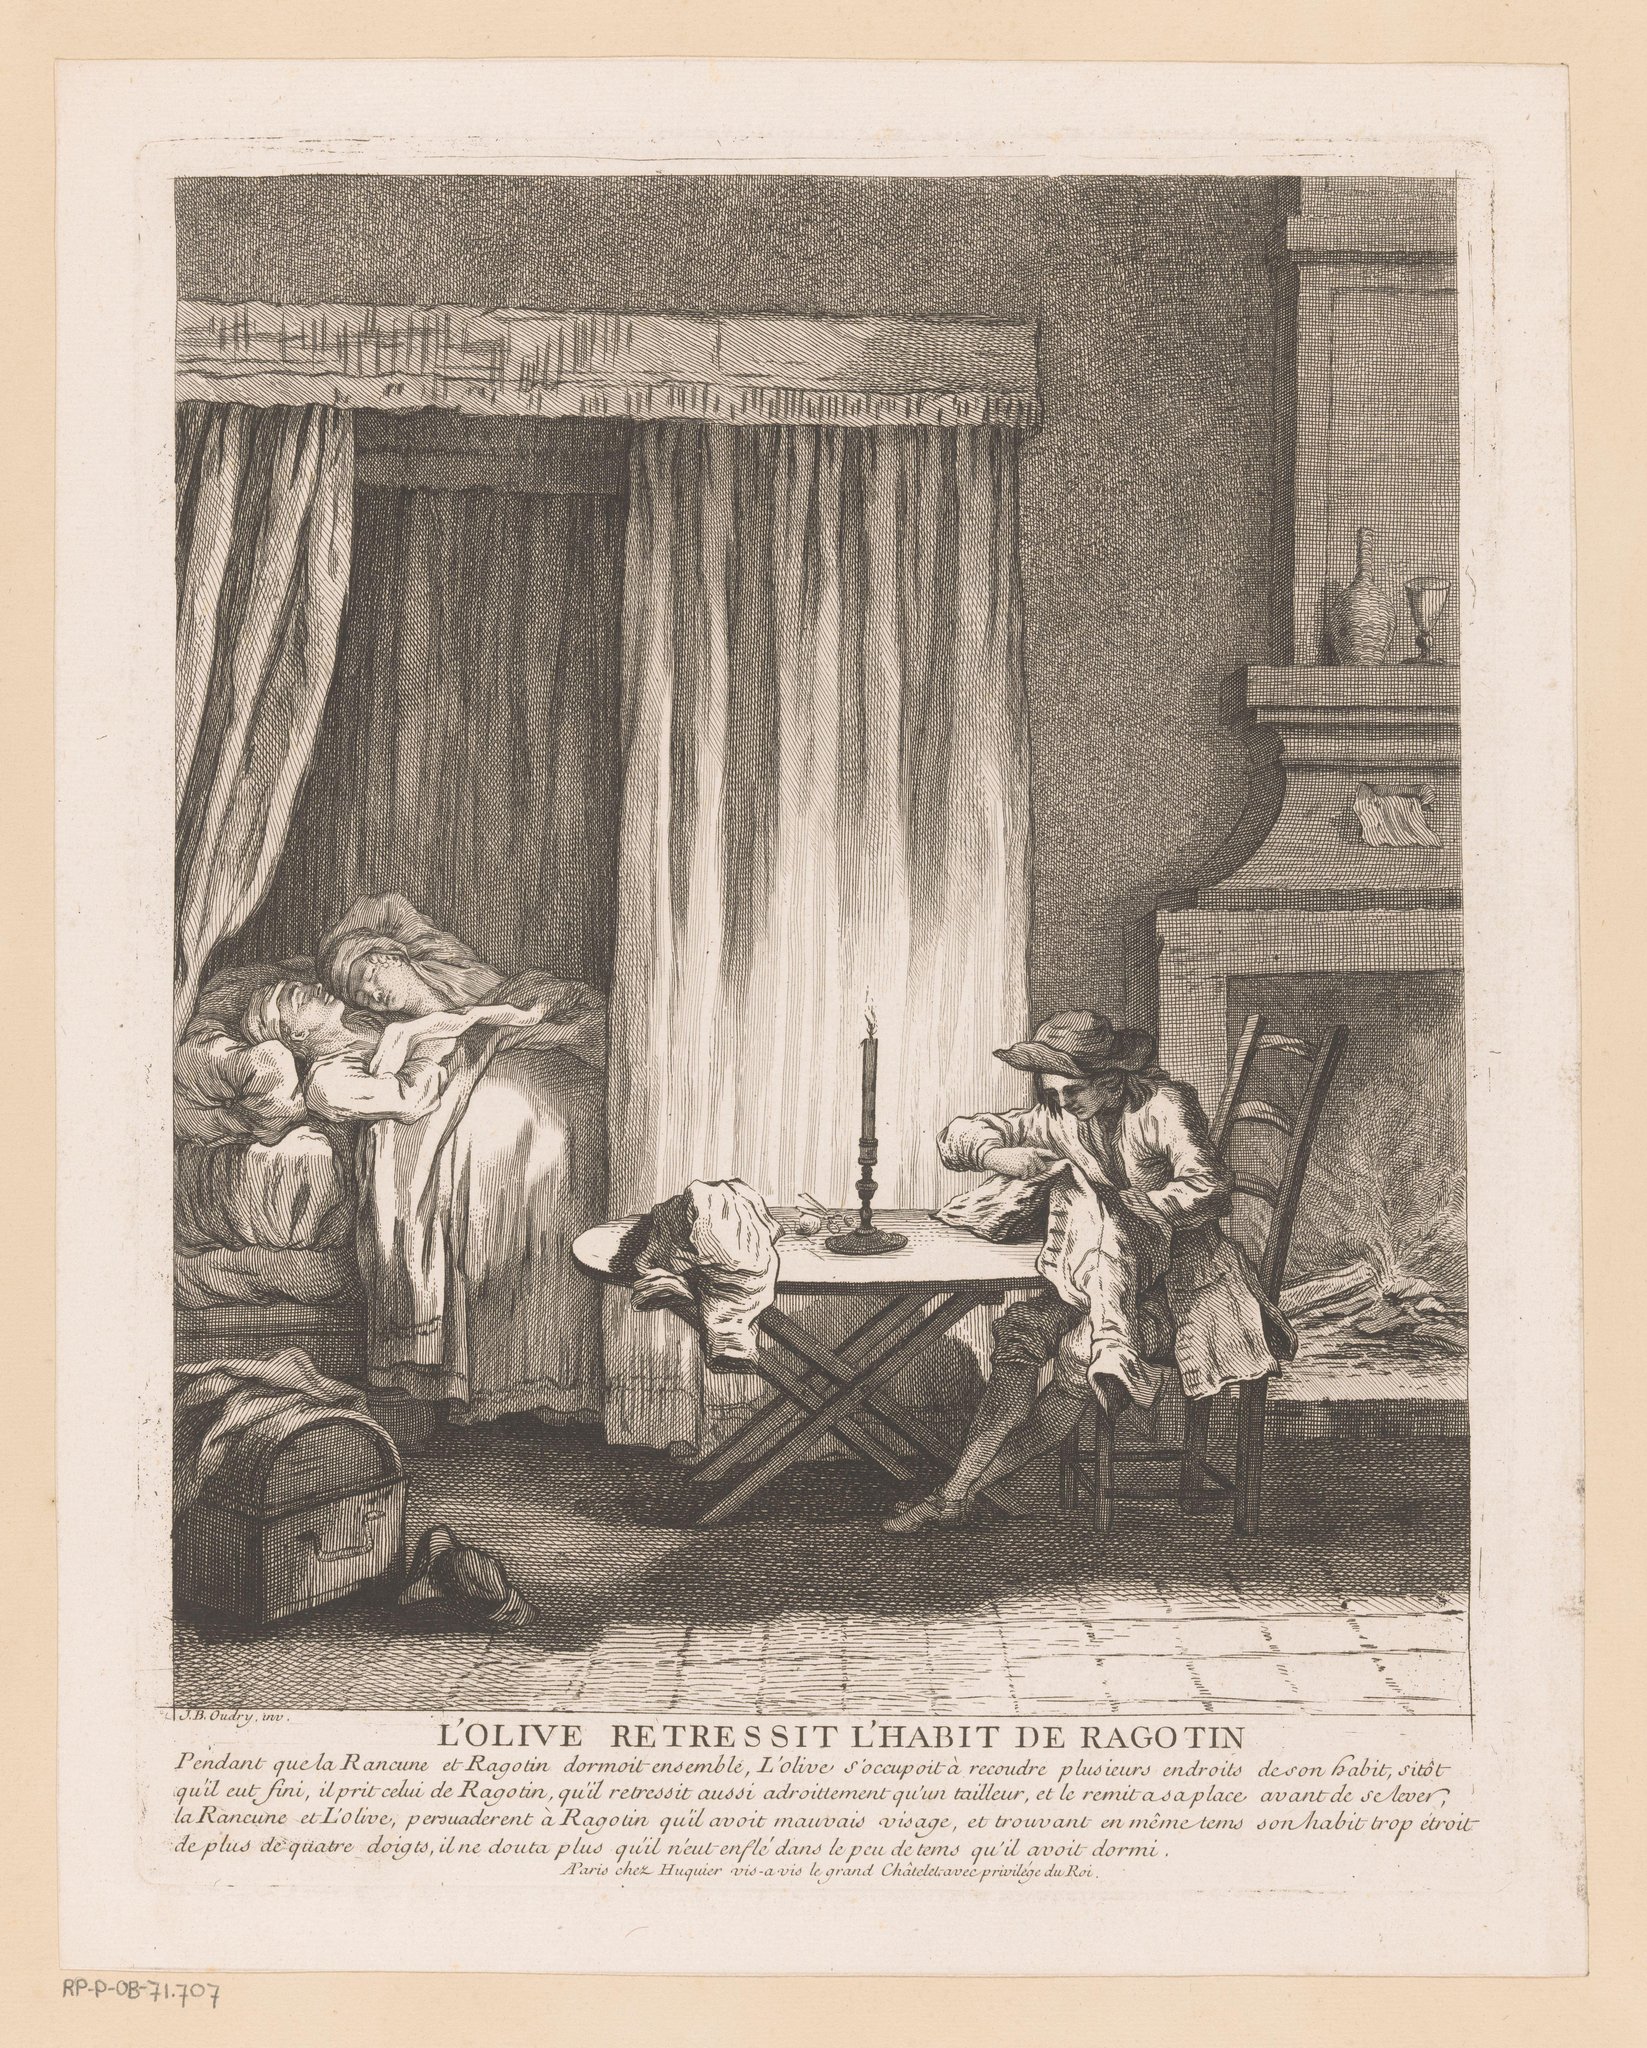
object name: print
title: Scènes uit de Roman Comique van Scarron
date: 1705-1772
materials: paper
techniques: engraving, etching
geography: france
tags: mending, repairing ~ clothes, (scarron, roman comique) specific works of literature (with author, title)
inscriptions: collector's mark: Lugt 240